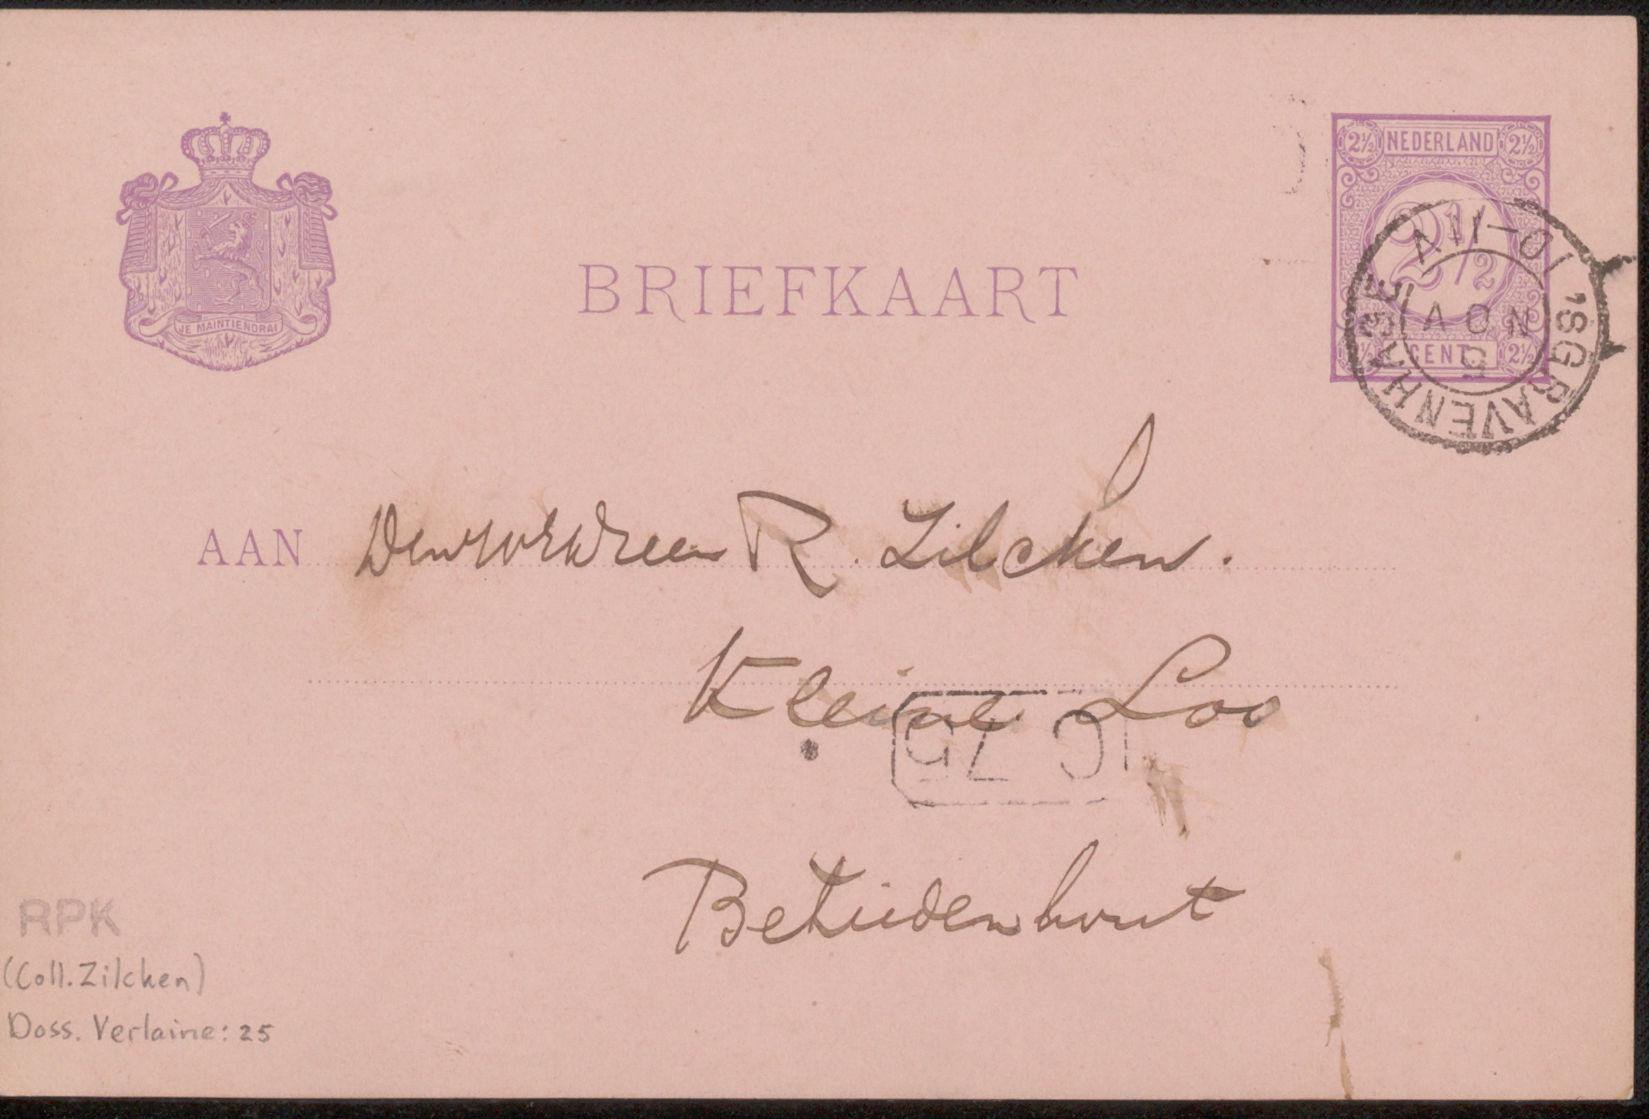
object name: postcard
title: Briefkaart aan Philip Zilcken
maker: Anonymous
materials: cardboard, ink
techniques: pen, writing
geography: the hague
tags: paul verlaine, engineer, gerard johan staal, the hague, painter, draughtsman, philip zilcken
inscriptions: collector's mark: ‘RPK’